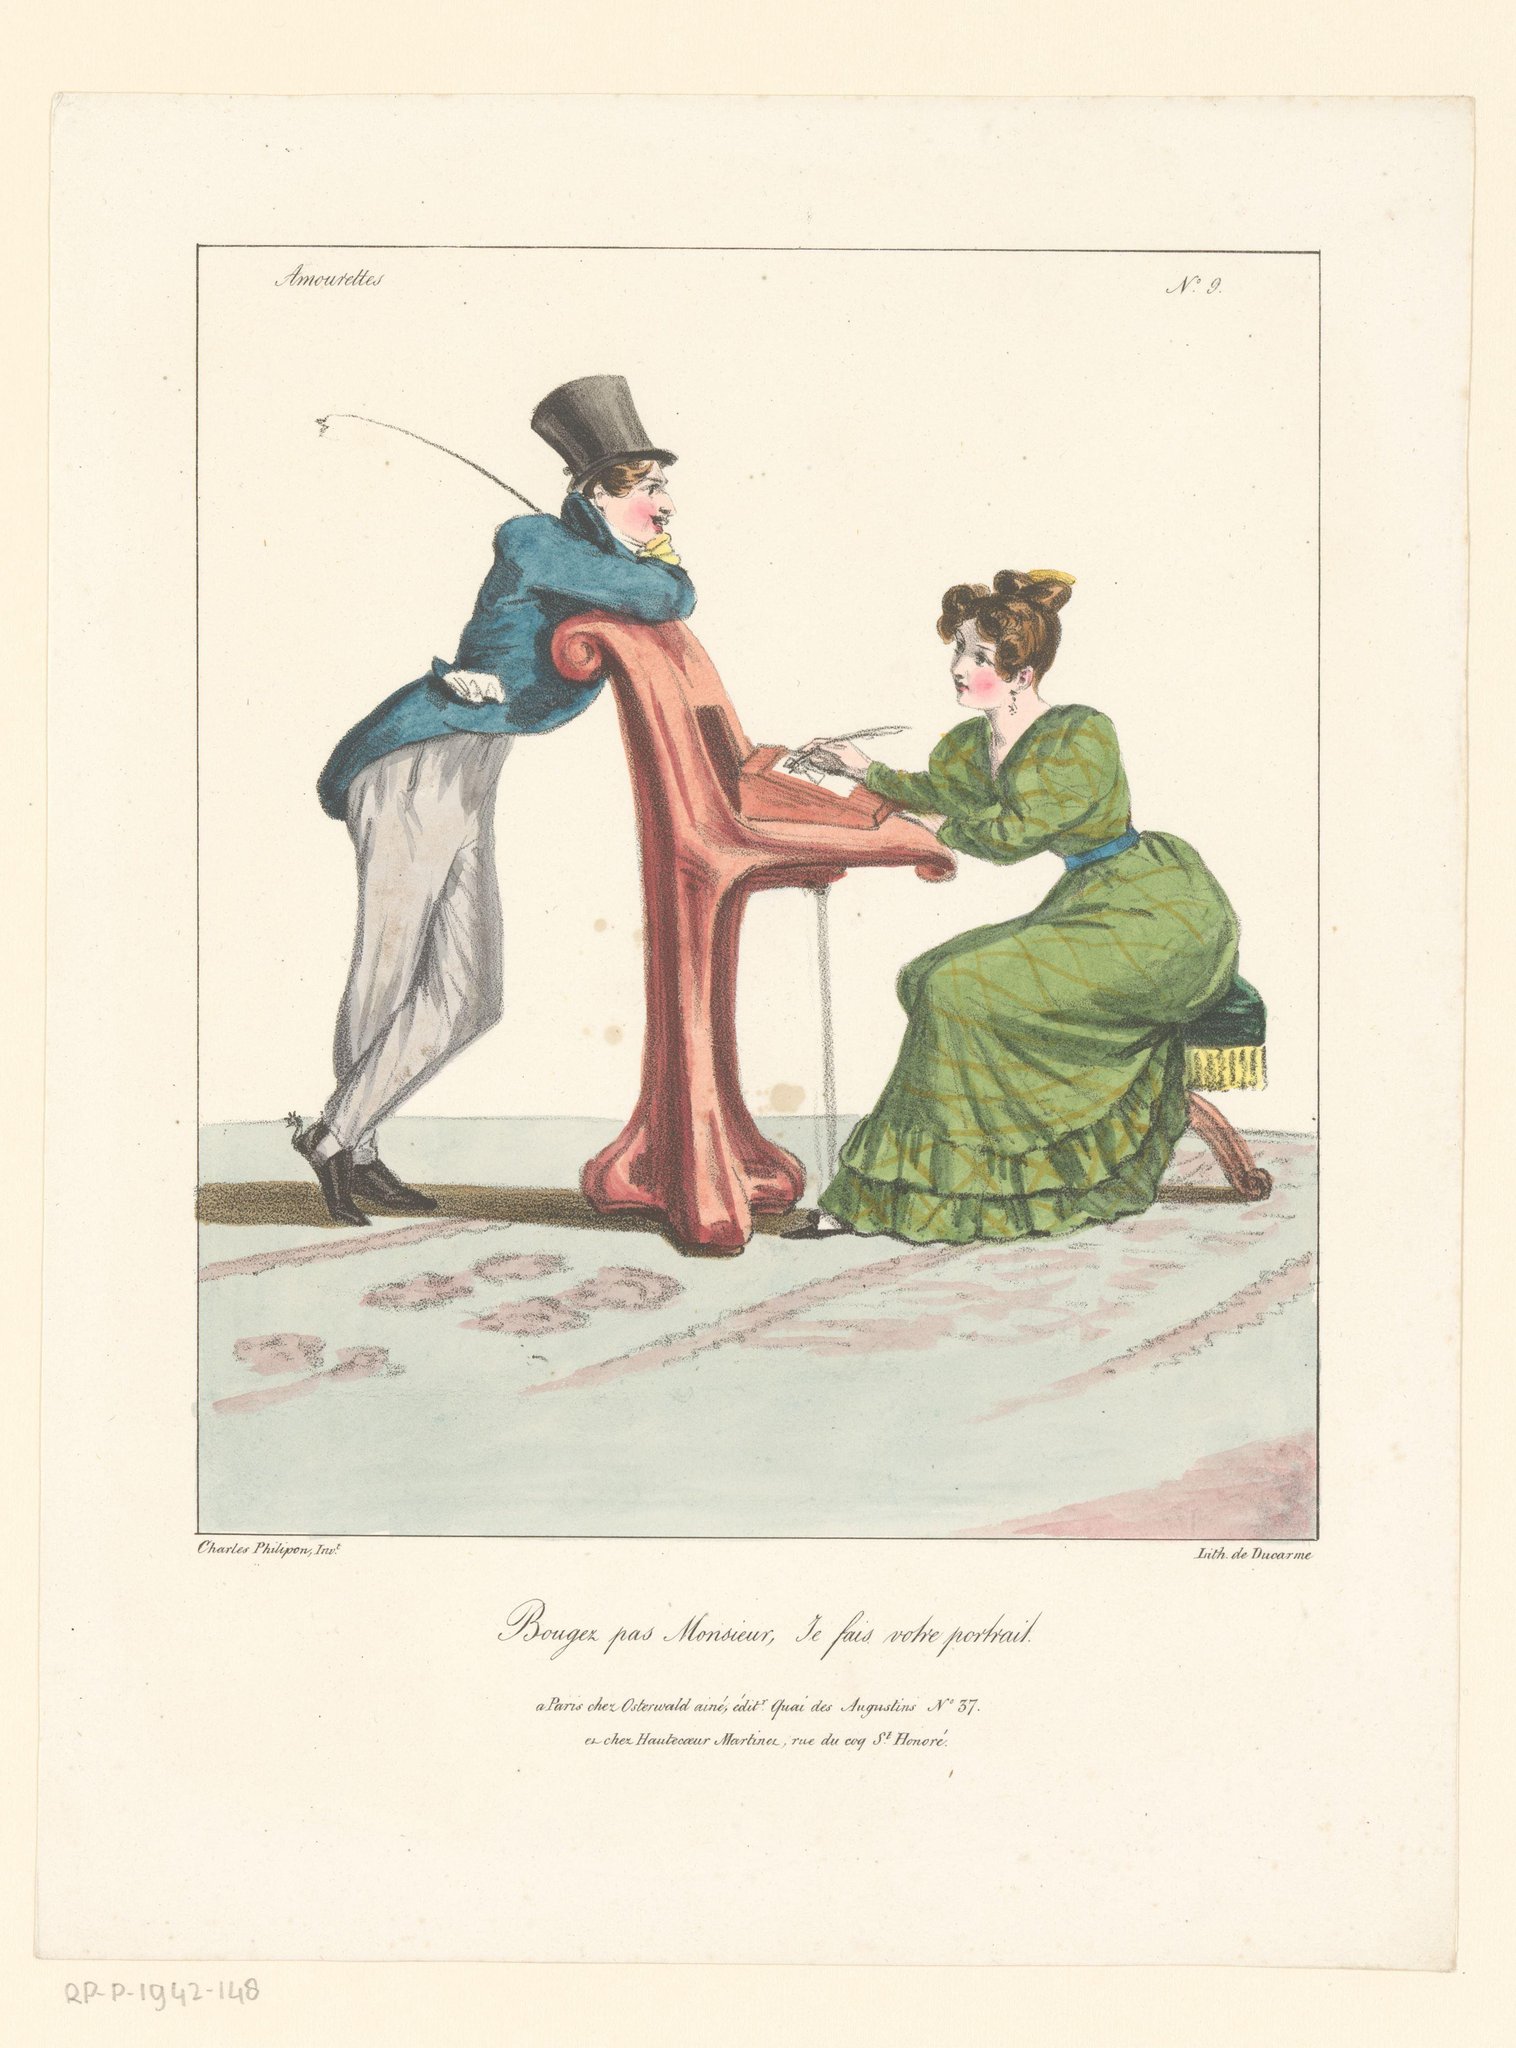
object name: print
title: Liefdestaferelen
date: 1827-1829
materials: paper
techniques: hand coloring, lithograph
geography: paris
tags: historical persons, lovers; courting, flirting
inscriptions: collector's mark: Lugt 2228, collector's mark: Lugt 2760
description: Serie bestond in eerste instantie uit achttien prenten maar is later uitgebreid, onduidelijk naar hoeveel prenten precies.